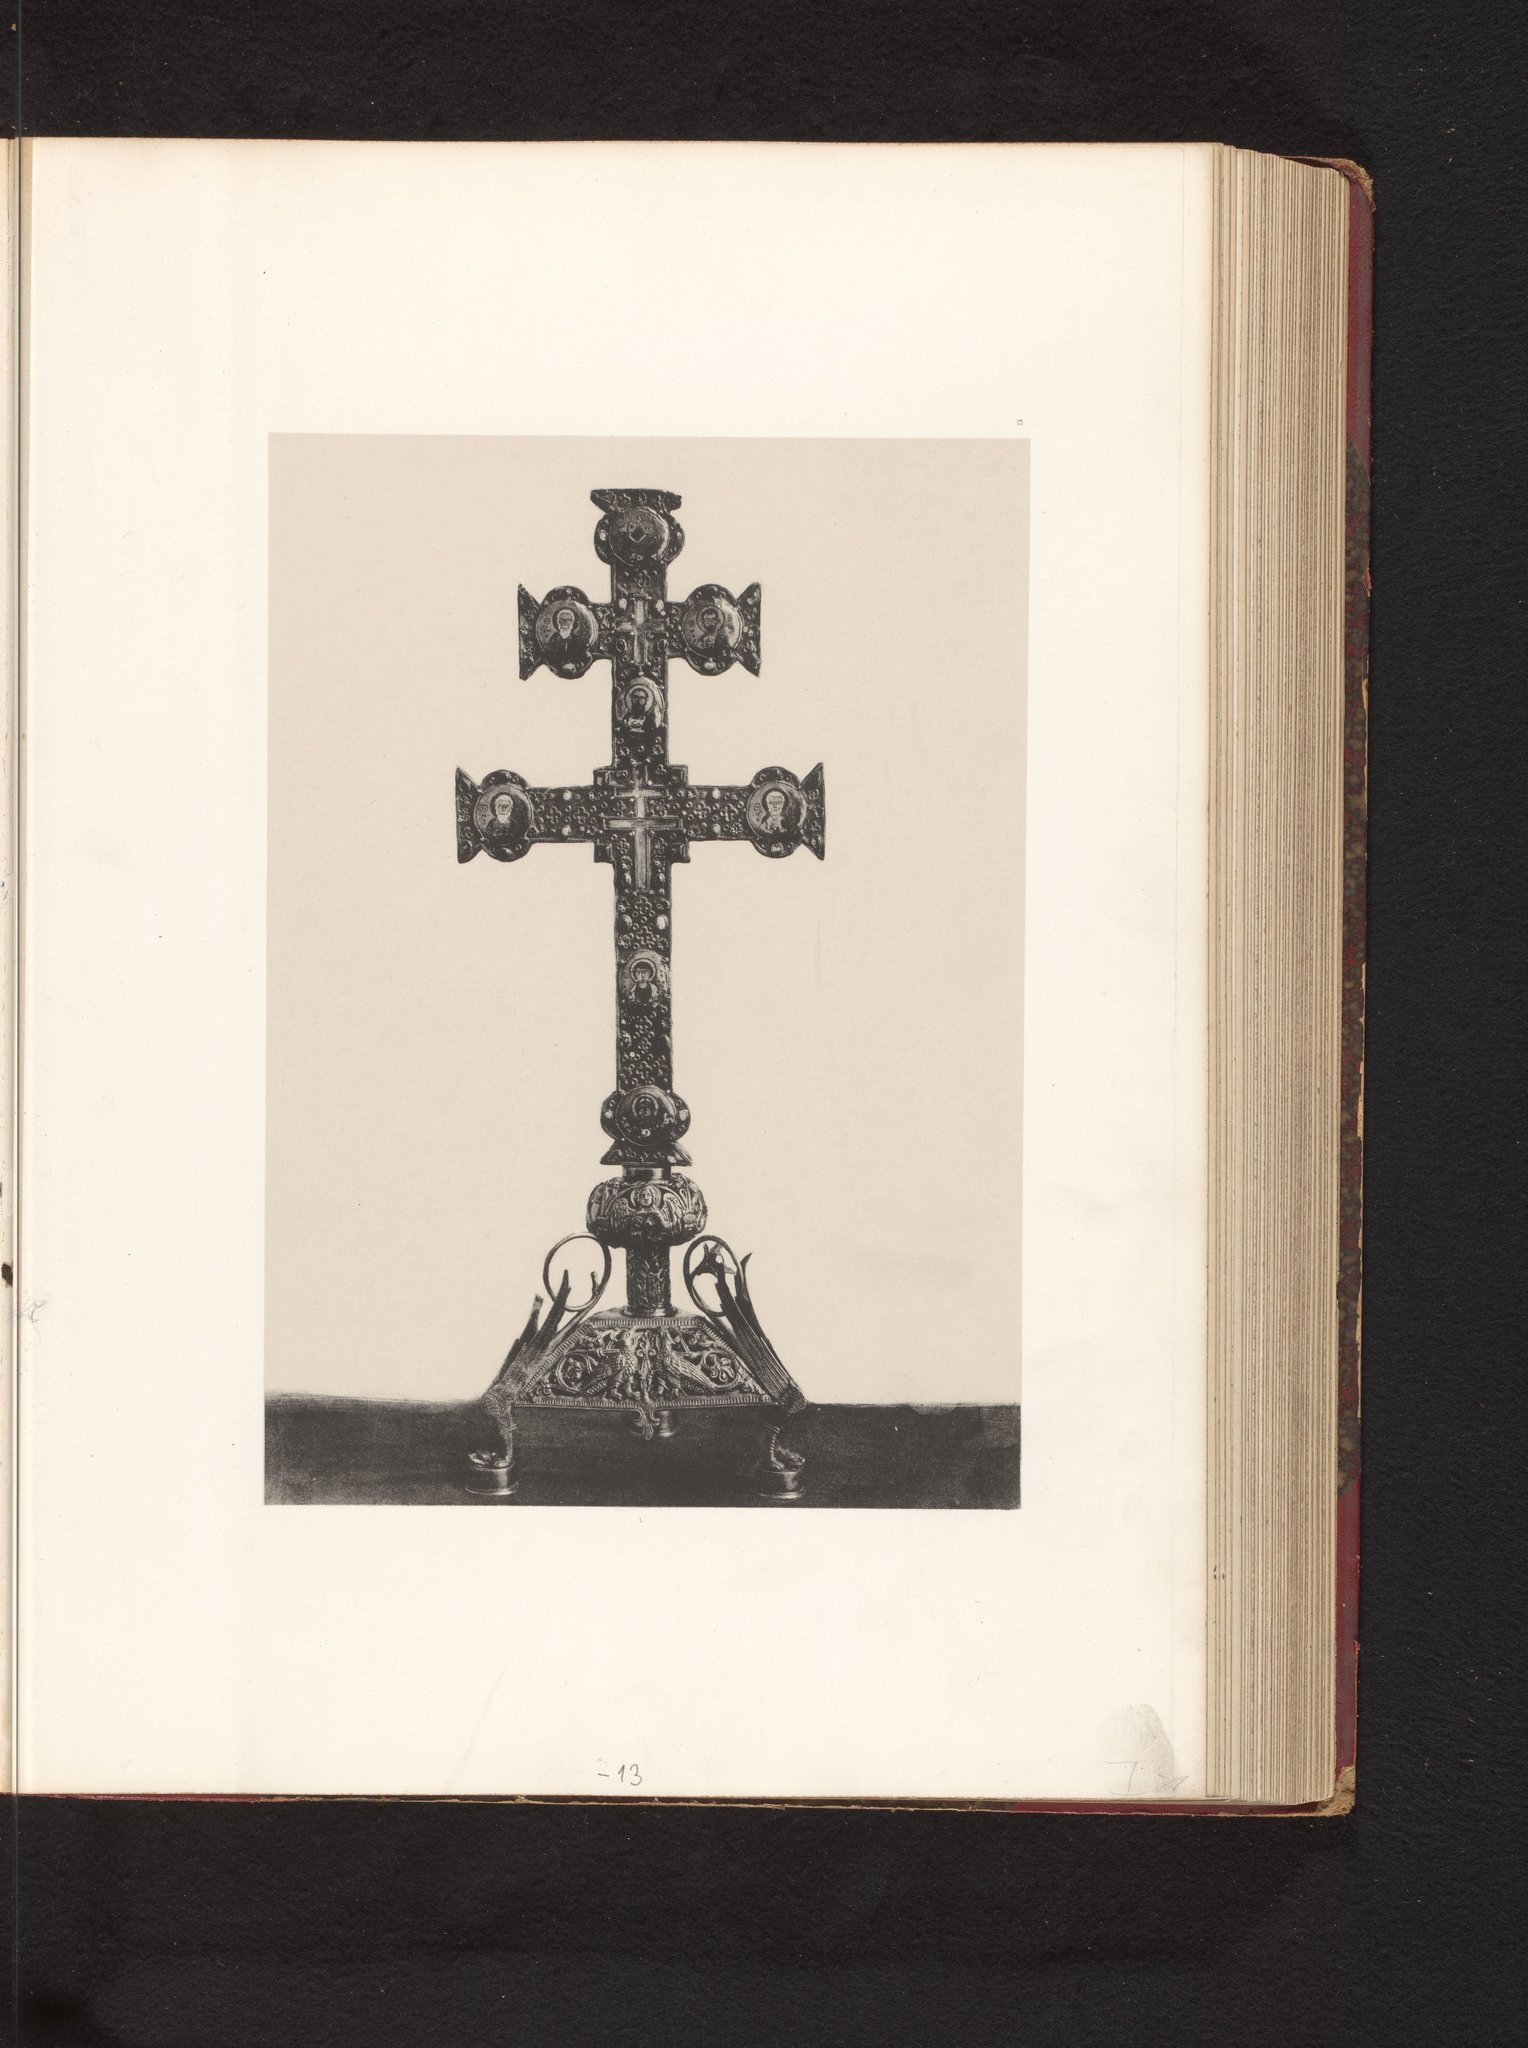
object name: photomechanical print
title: Gouden kruis met relikwie uit de collectie van de Soeurs de Notre-Dame de Namur, opgesteld op een tentoonstelling over religieuze objecten uit de middeleeuwen en renaissance in 1864 in Mechelen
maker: joseph maes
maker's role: fotograaf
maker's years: 1838-1908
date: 1864-1866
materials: paper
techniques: photolithography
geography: antwerp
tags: piece of sculpture (+ precious metals ~ arts), relics (and reliquaries), mechelen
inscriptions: number: ‘-13’, number: ‘I’, number: ‘1’